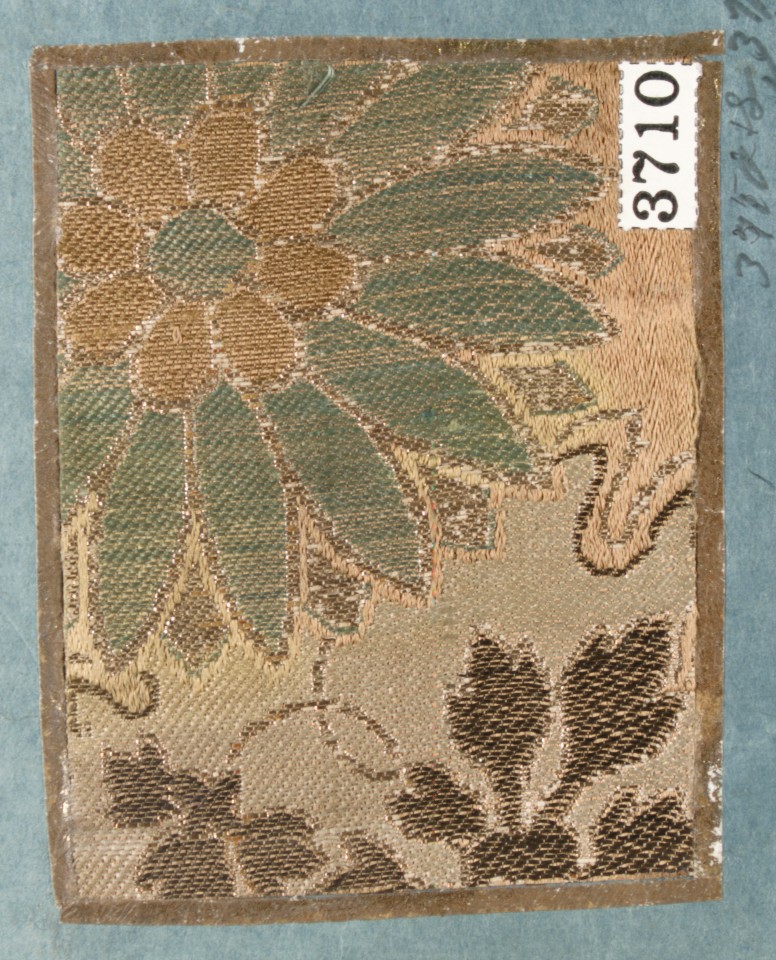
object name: sample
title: Textile Sample from Sample Book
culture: japanese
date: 1801-1900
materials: silk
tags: flowers